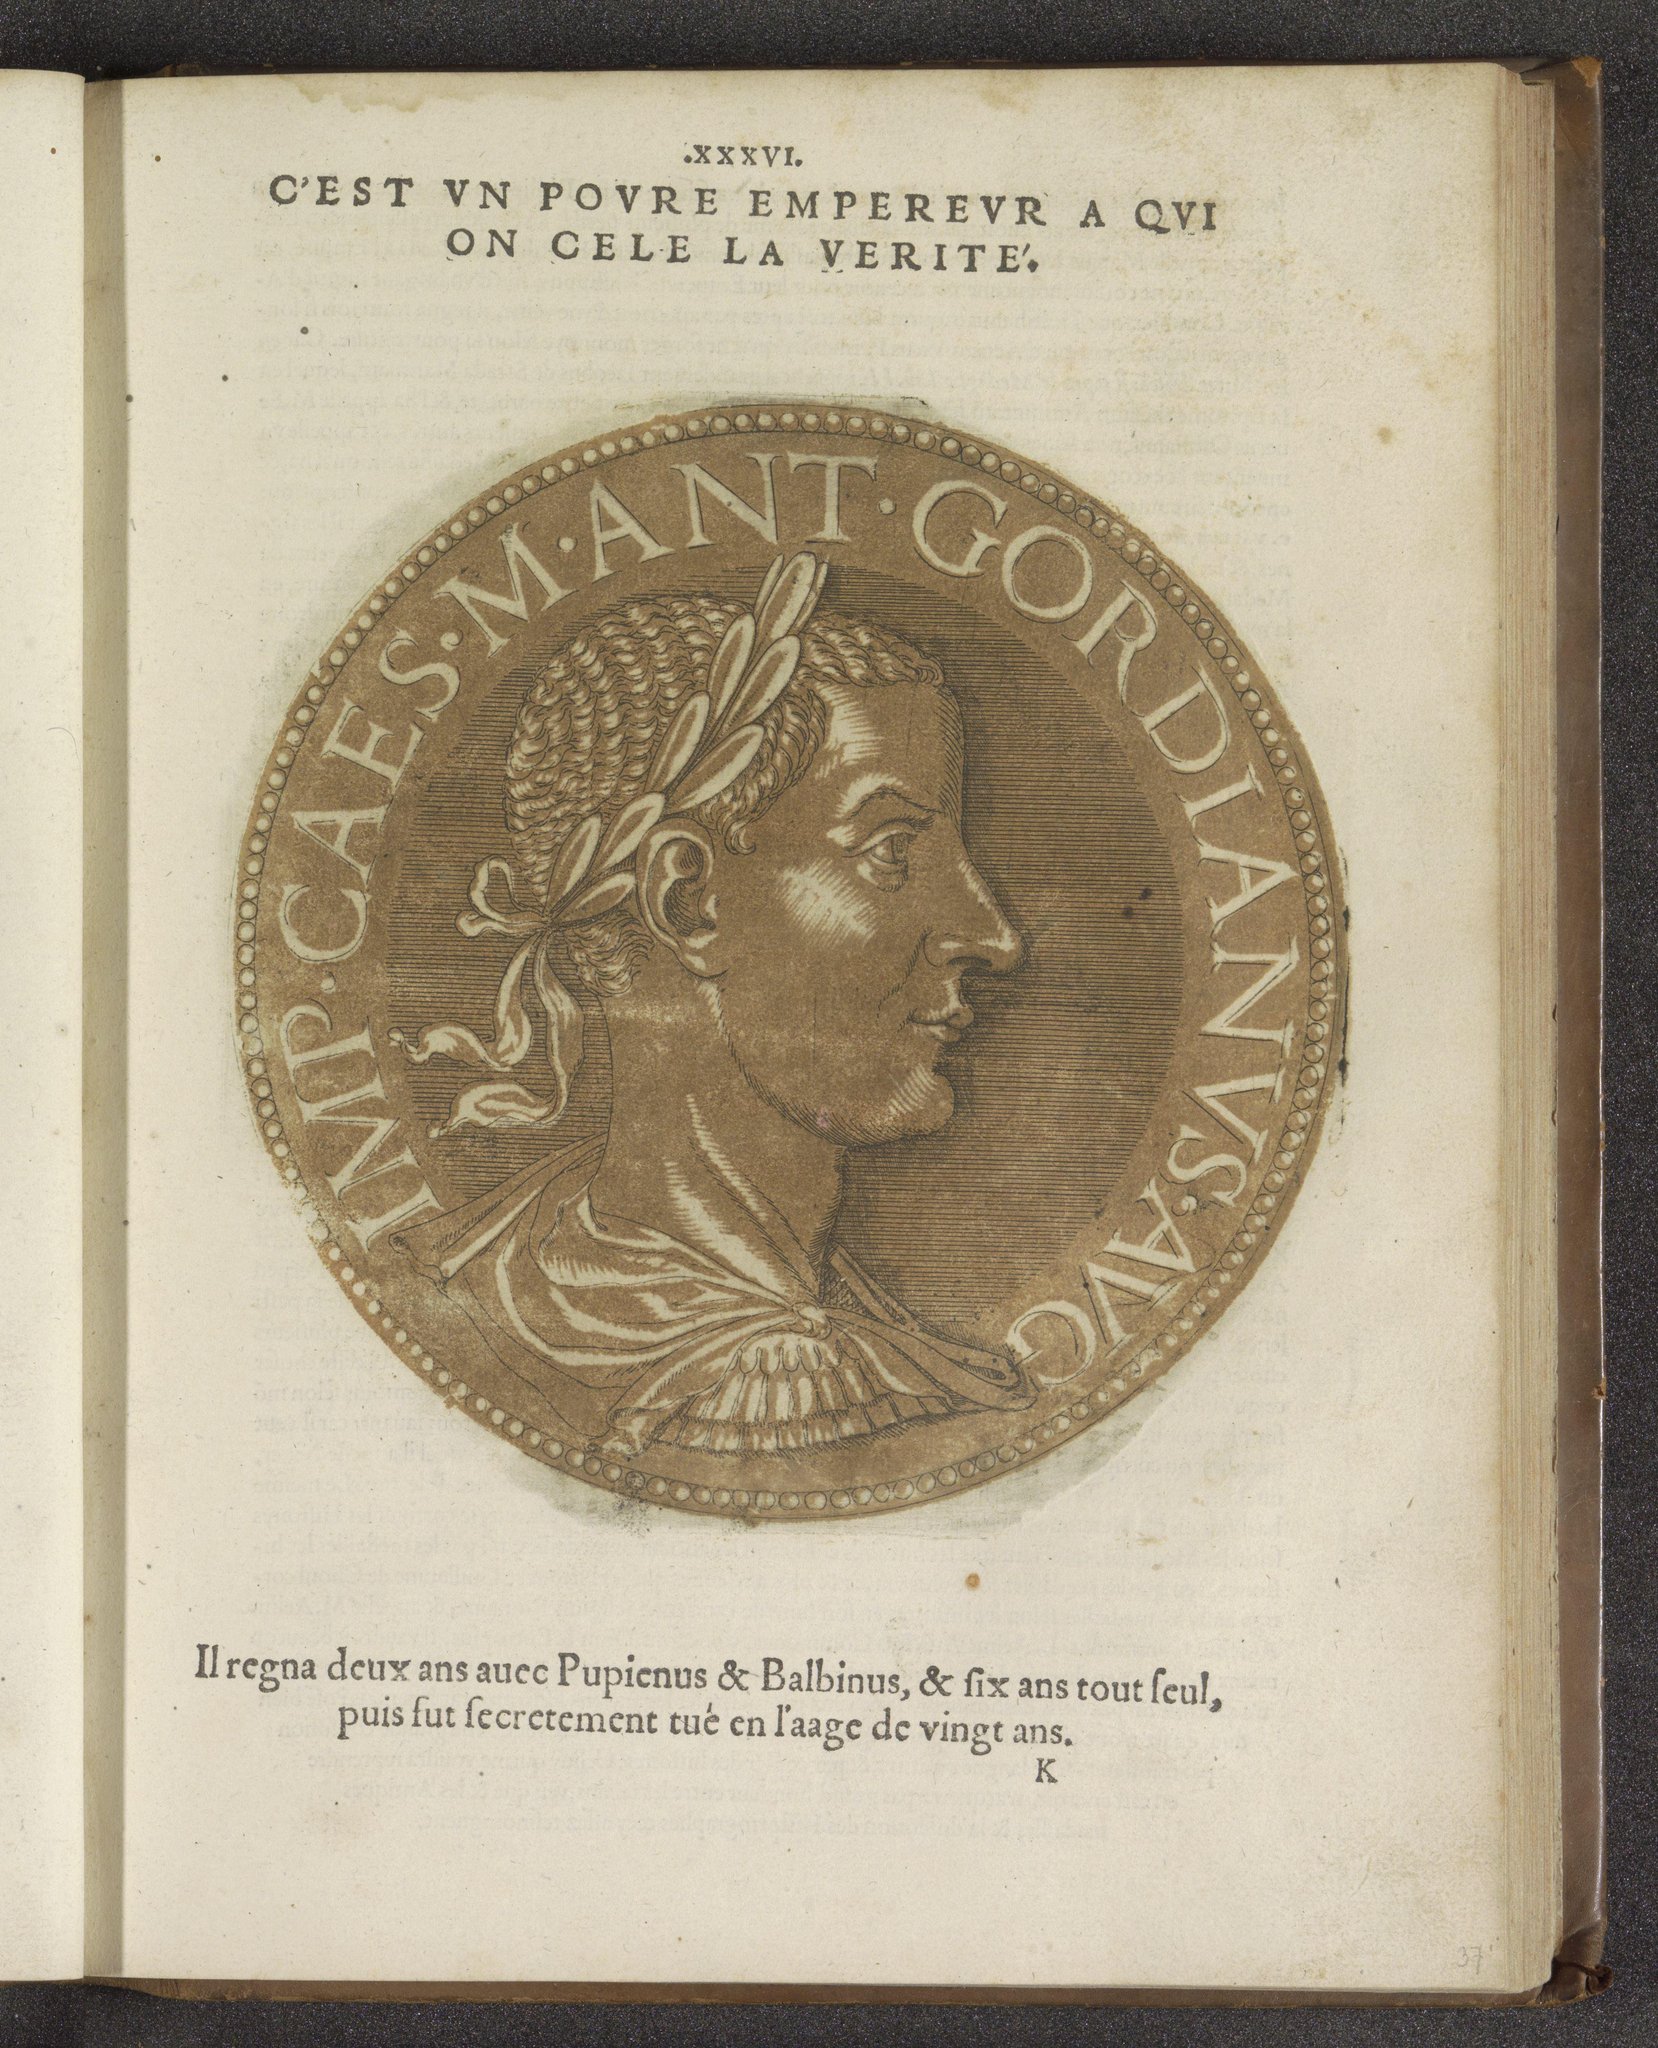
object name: print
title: Les images presque de tous les empereurs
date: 1557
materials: paper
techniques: woodcut, etching, letterpress printing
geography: antwerp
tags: emperor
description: Portret van keizer Gordianus III, op een munt met randschrift. De prent maakt deel uit van een boek over de keizers vanaf Julius Caesar tot en met Karel V en zijn broer Ferdinand.